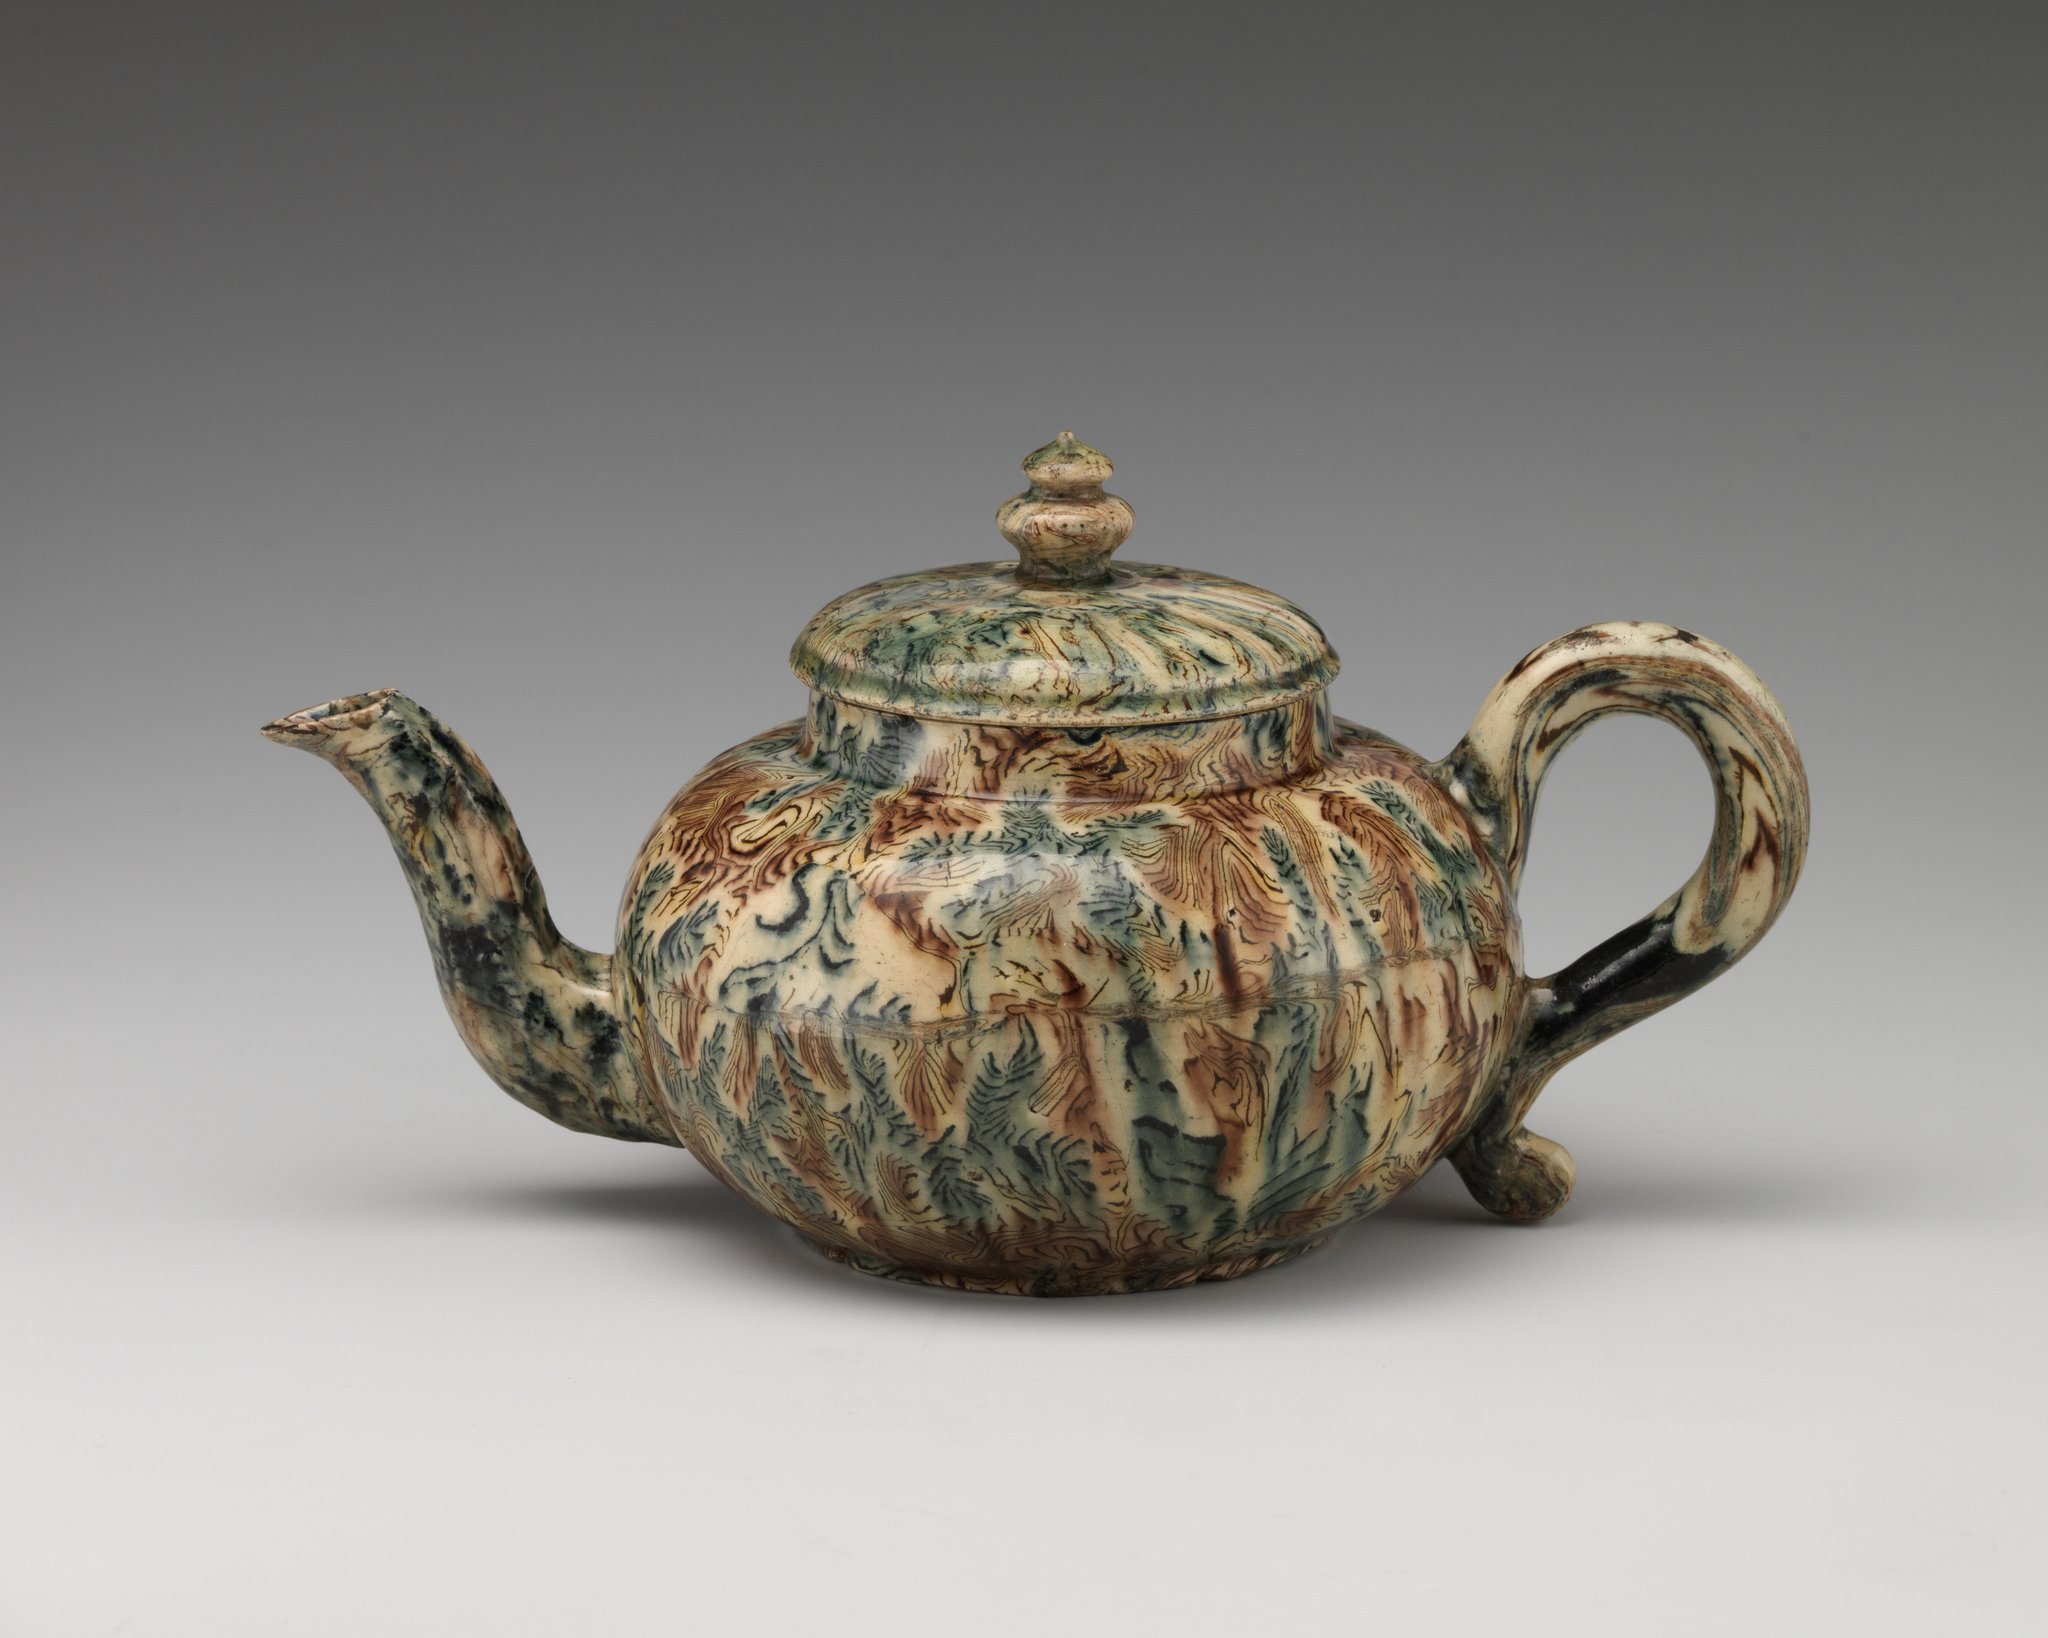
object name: teapot with cover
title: Teapot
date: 1750-1765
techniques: glazing